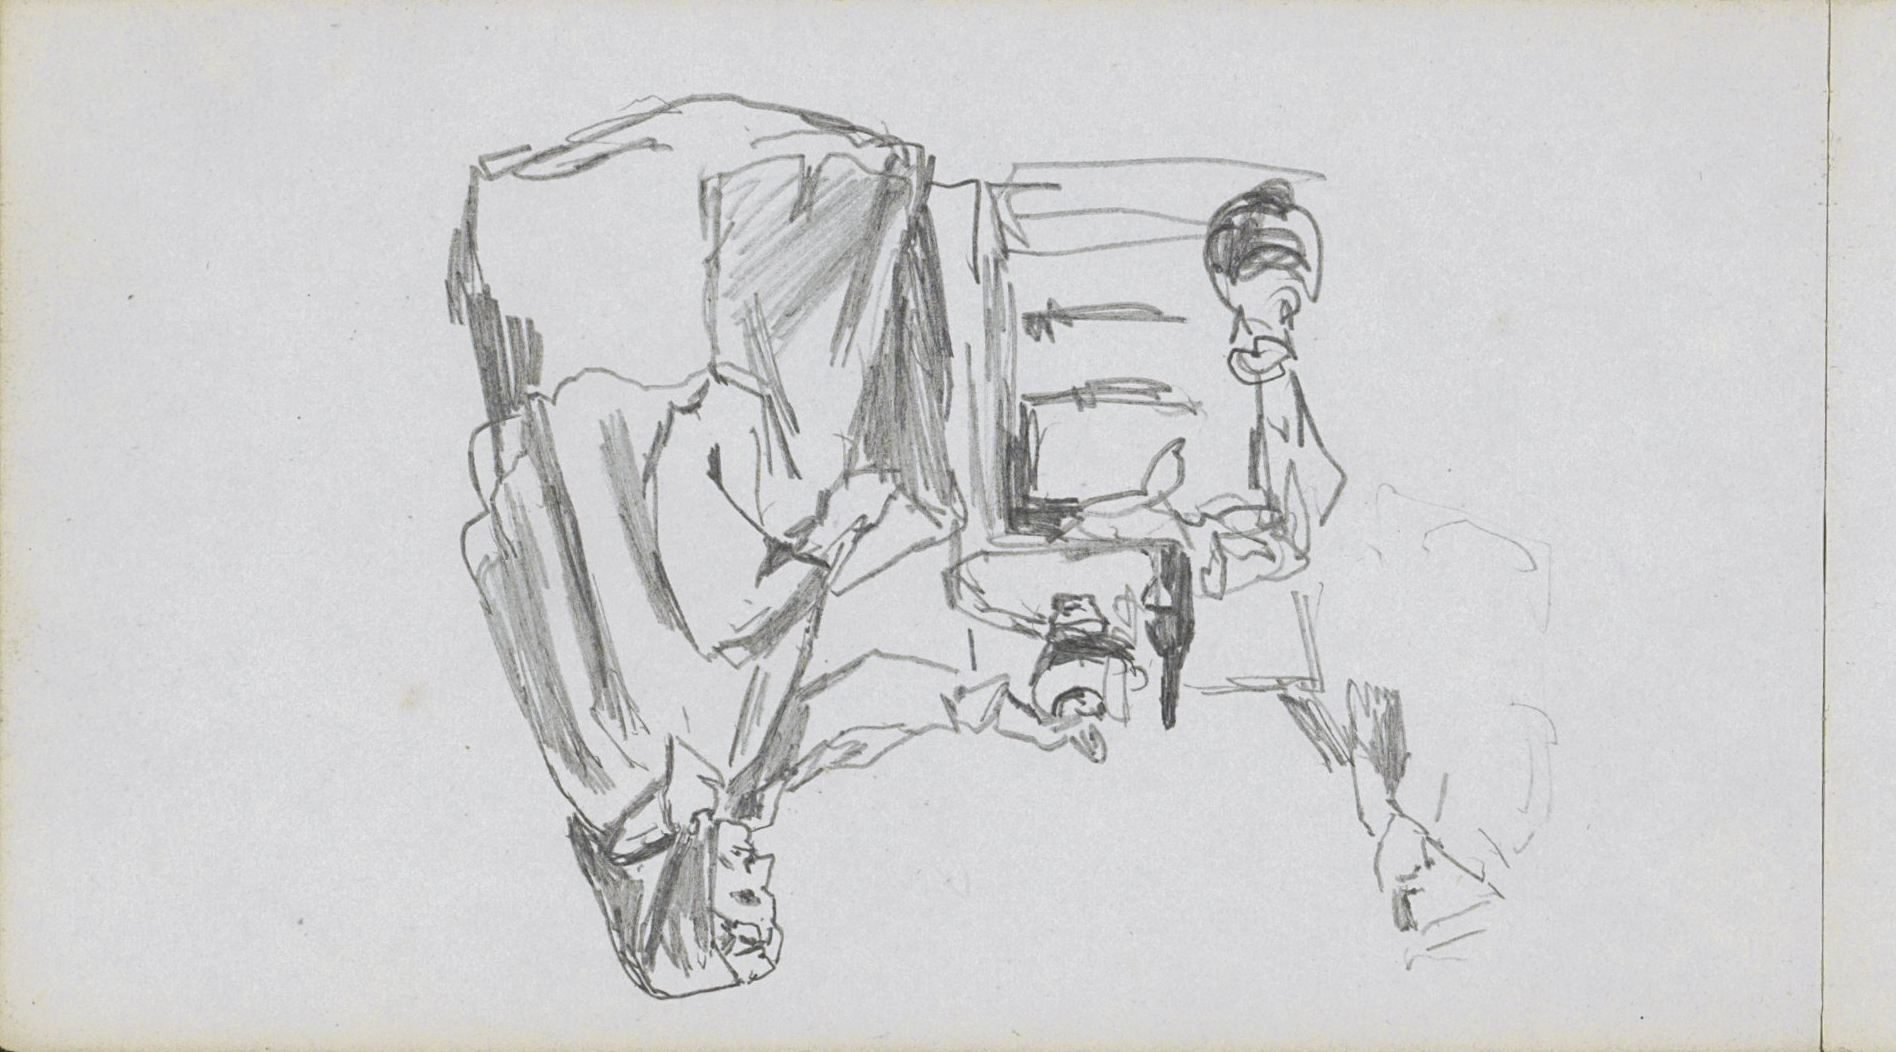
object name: sketchbook leaf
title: Oude vrouw zittend aan een tafel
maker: johan hendrik weissenbruch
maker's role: draughtsman, painter, print maker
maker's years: 1824-1903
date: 1834-1903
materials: paper, pencil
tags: sitting figure (+ old female (human being)), laid table: table-ware, table-decoration, etc.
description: Vermoedelijk schenkt de vrouw drinken uit een kan of pot. Aan de andere zijde van de tafel vermoedelijk een tweede figuur. Blad 28 verso uit een schetsboek met 39 bladen.